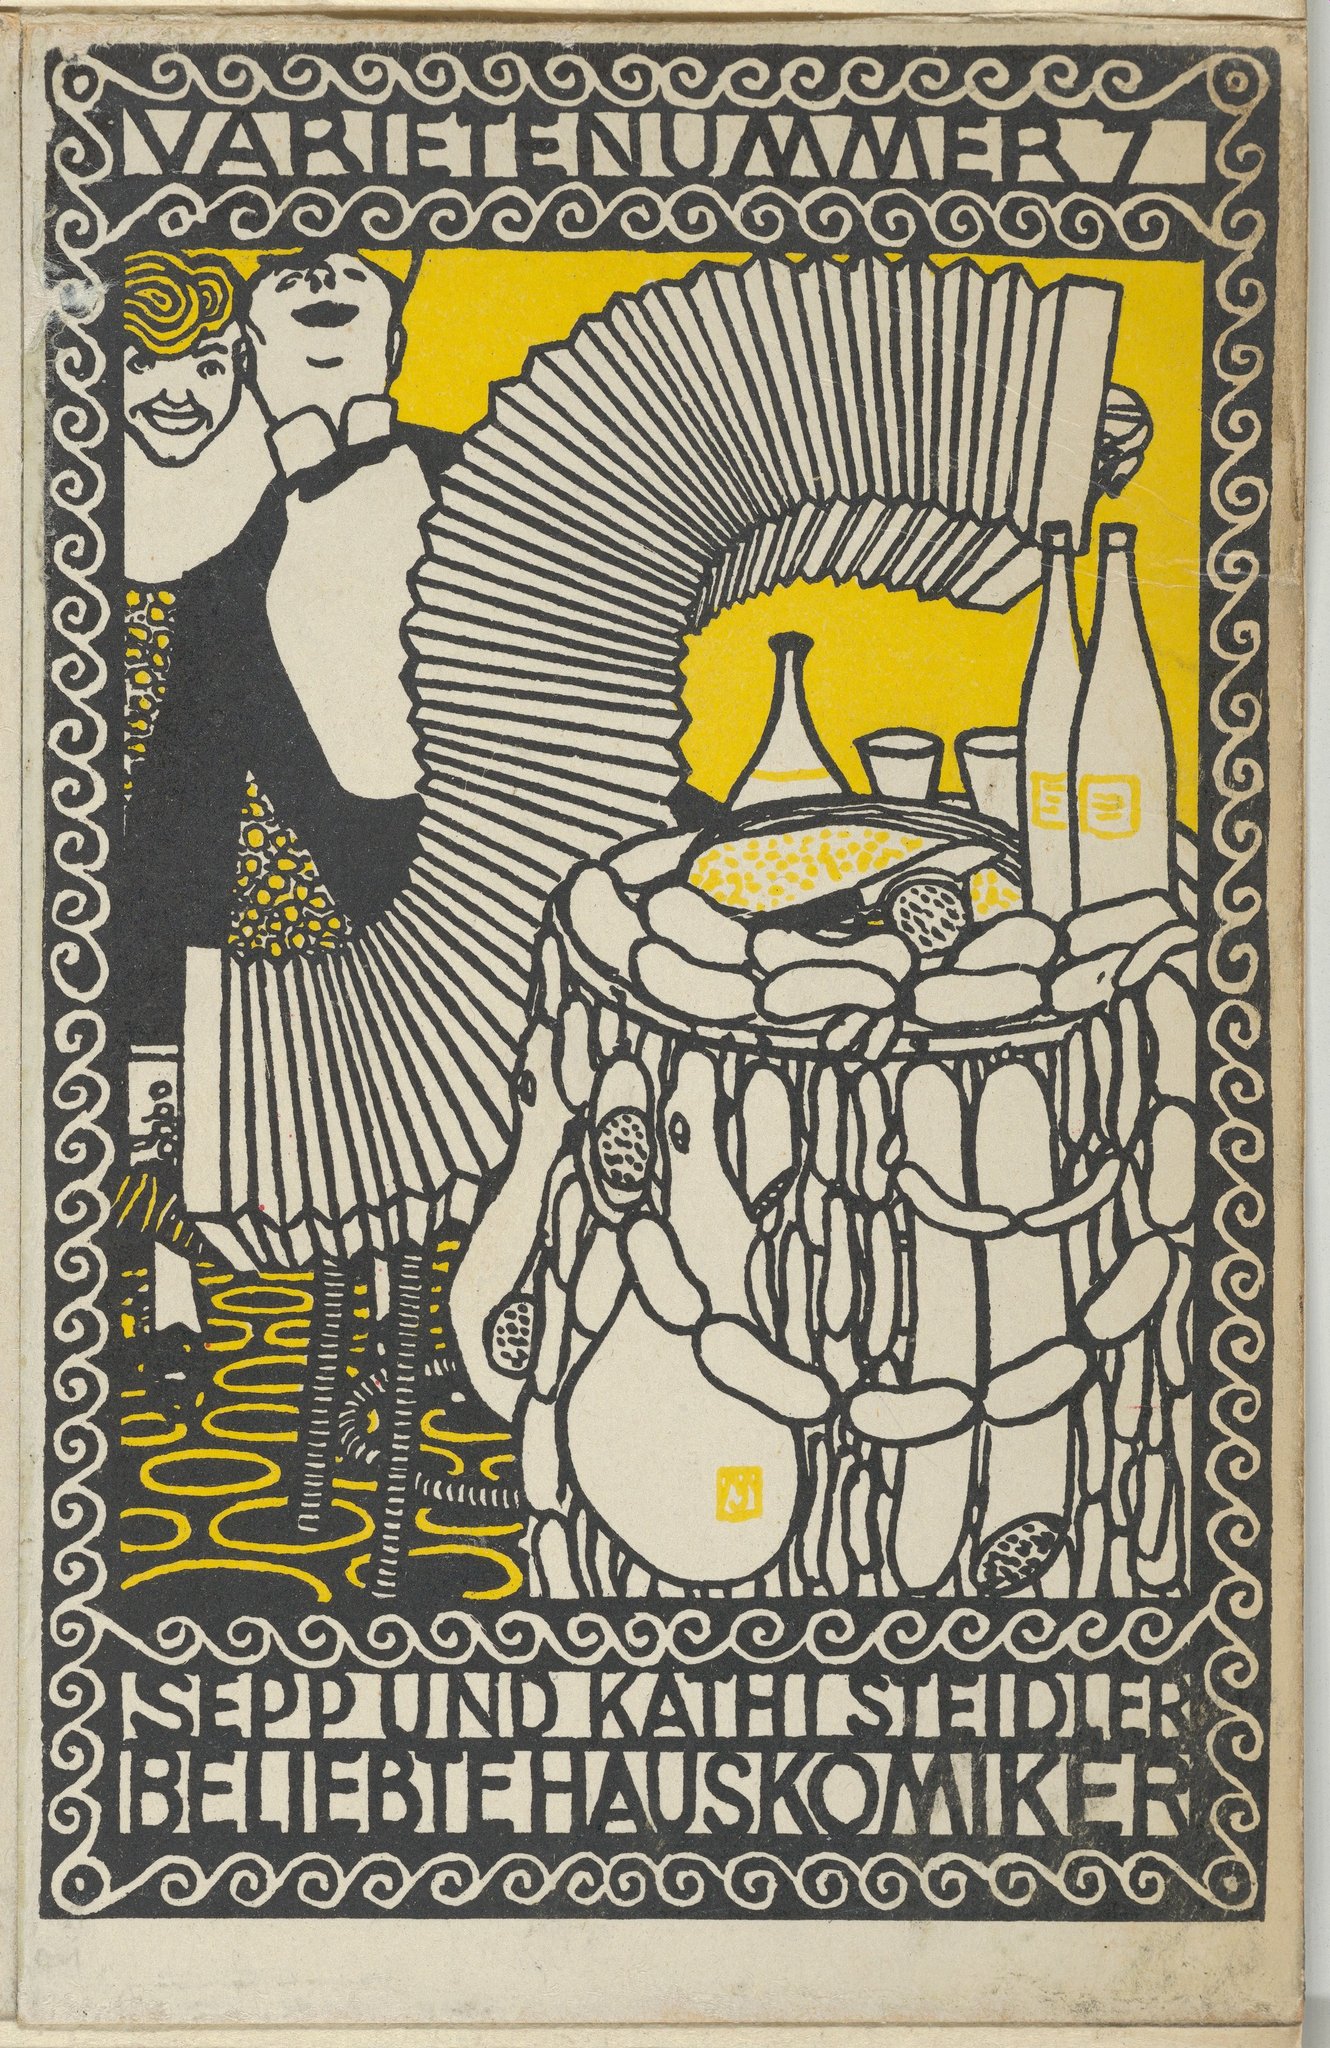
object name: print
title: Variety Act 7: Sepp and Kathi Steidler, Popular House Comedians (Varietenummer 7: Sepp und Kathi Steidler, Beliebte Hauskomiker)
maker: moriz jung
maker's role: artist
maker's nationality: austrian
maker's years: 1885-1915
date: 1907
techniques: lithograph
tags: accordions,actors